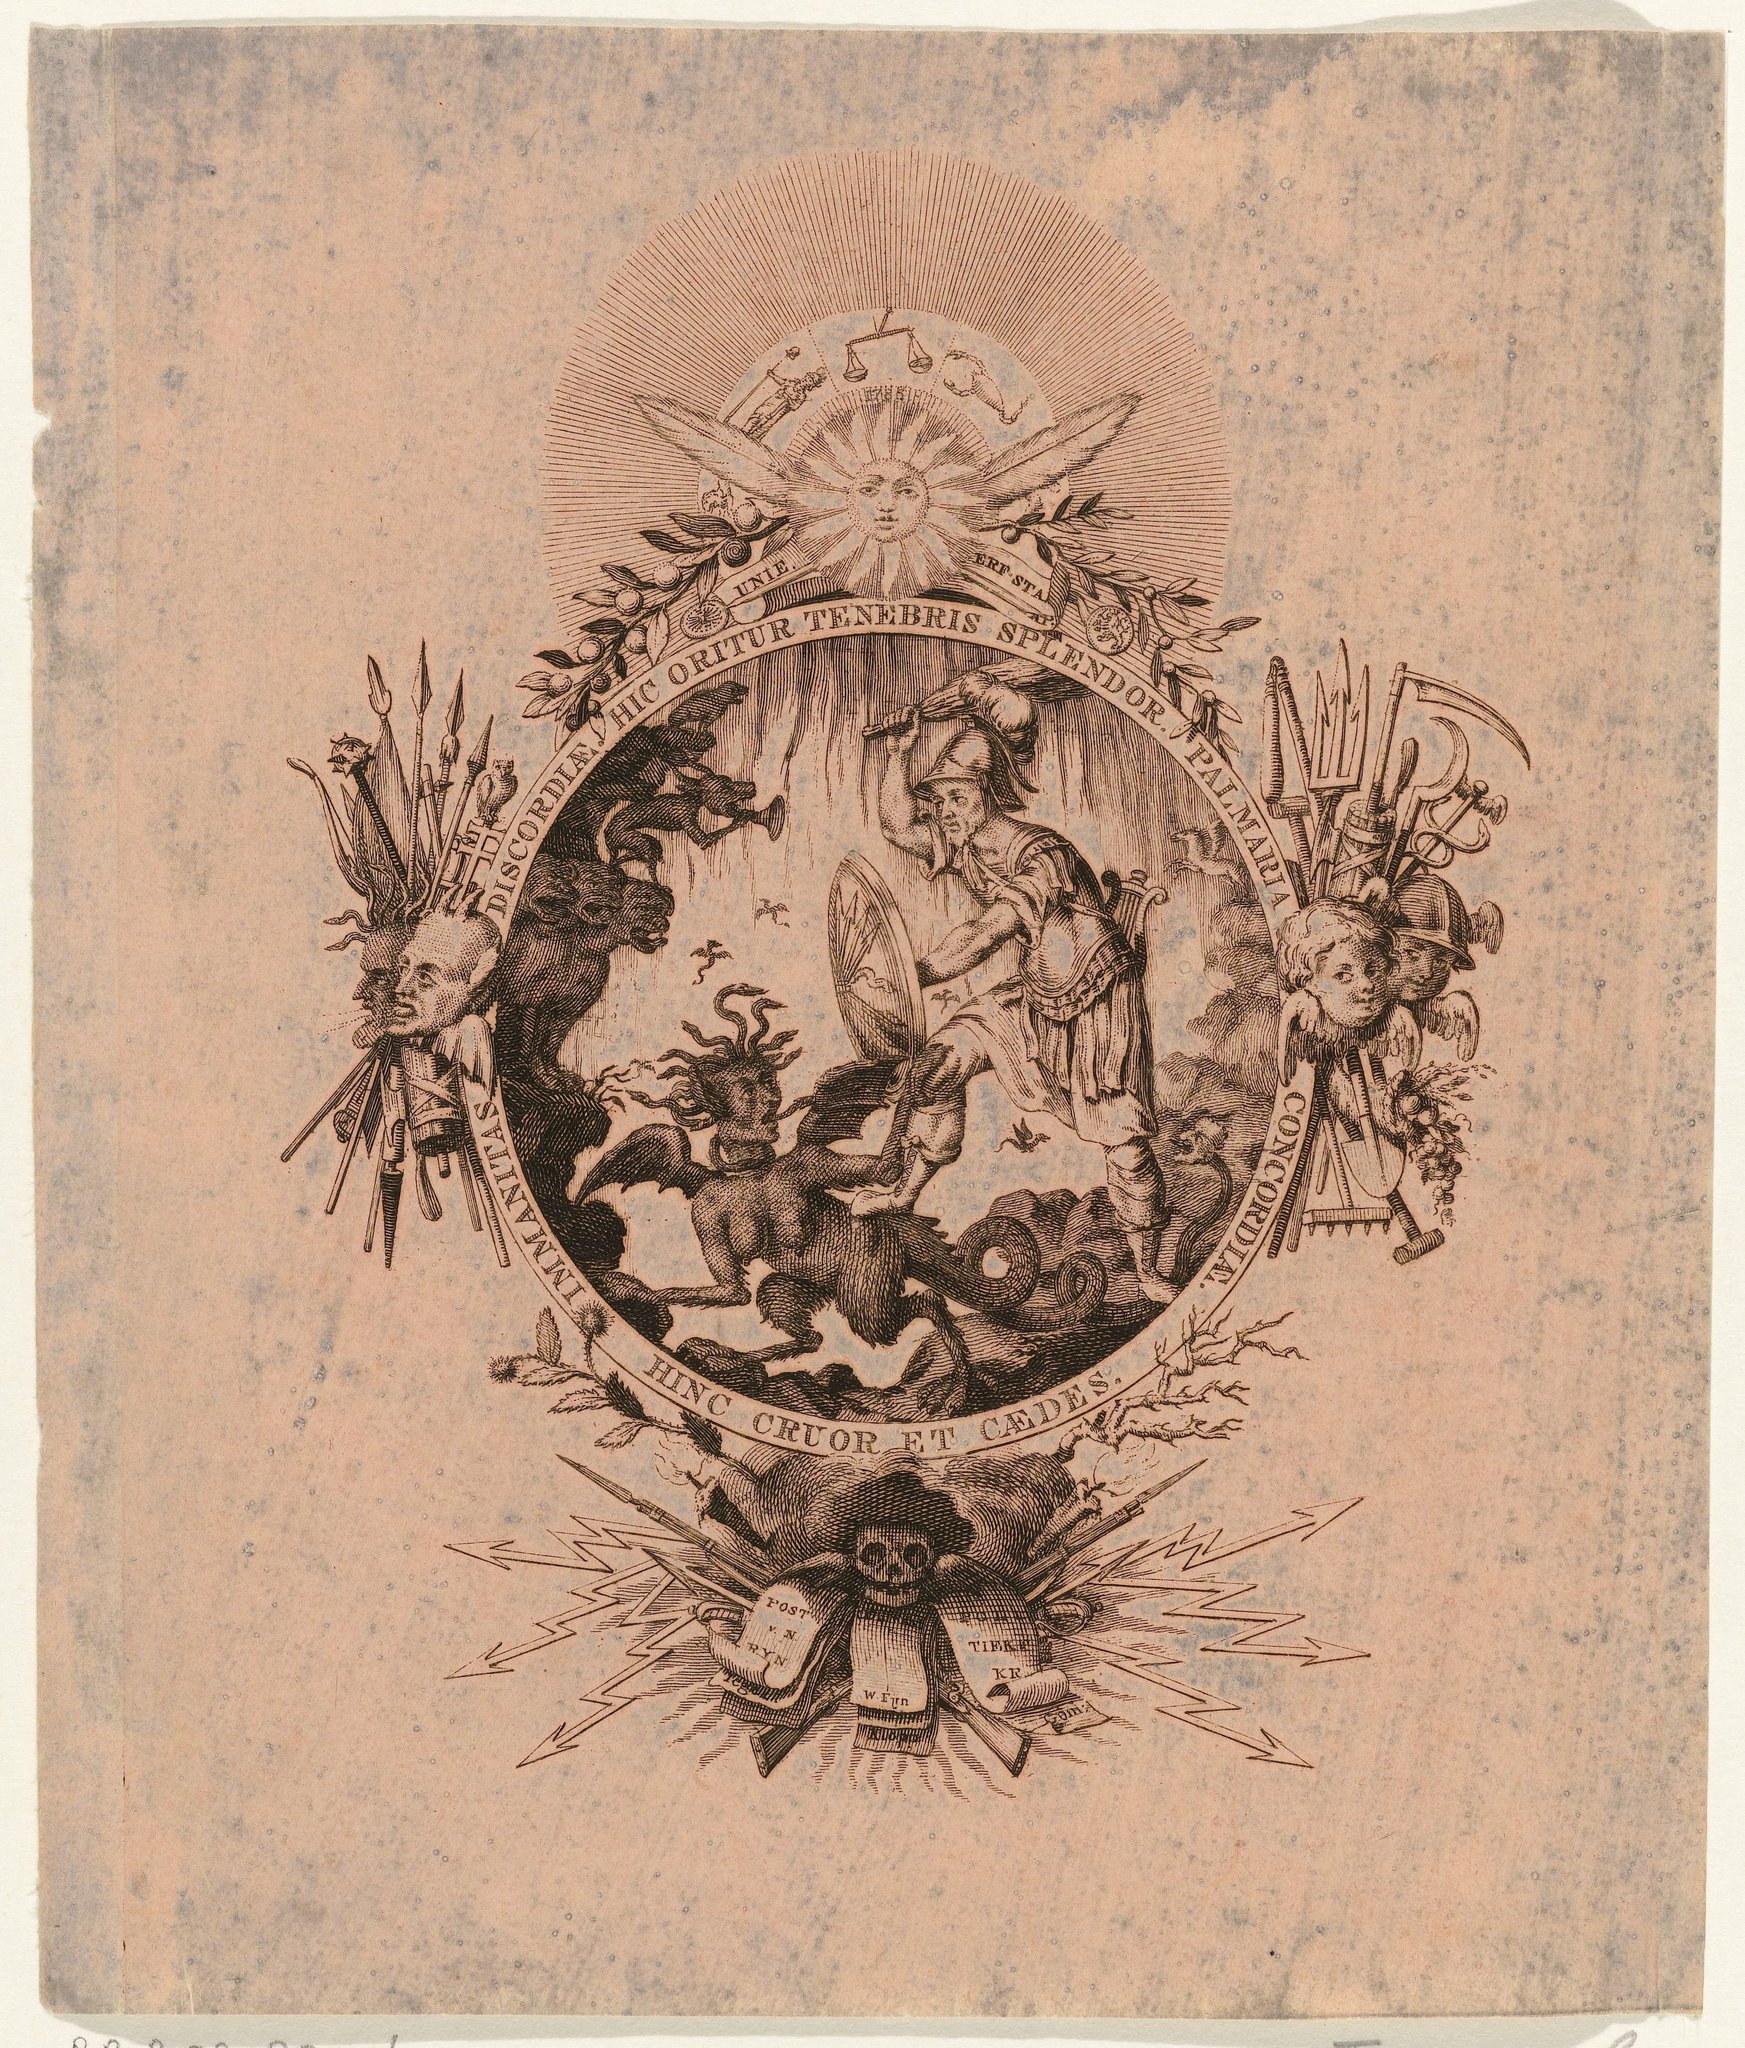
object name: print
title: Snerpende Hekelroede van een echten Vrank en Vryen Batavier, 1787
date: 1787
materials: paper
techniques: engraving, etching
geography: northern netherlands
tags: agreement, unity; 'concordia', 'concordia insuperabile', 'concordia militare', 'concordia di pace', 'unione civile' (ripa), disagreement, discord; 'discordia' (ripa)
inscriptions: collector's mark: Lugt 2228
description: Orangistische allegorische voorstelling waarin een Batavier als Hercules het monster van de Tweedracht naar de hel verjaagt. Aan de linkerzijde van het medaillon een trofee met de wapens van de Tweedracht, aan de rechterzijde een trofee met de wapens van de Eendracht. Bovenaan schijnt de zon met Oranjetak en olijftak, onderaan heerst duisternis met een doodskop en patriotse pamfletten. Met randschrift in het Latijn. Gebruikt in schotschrift van Johannes le Francq van Berkhey in 1787.